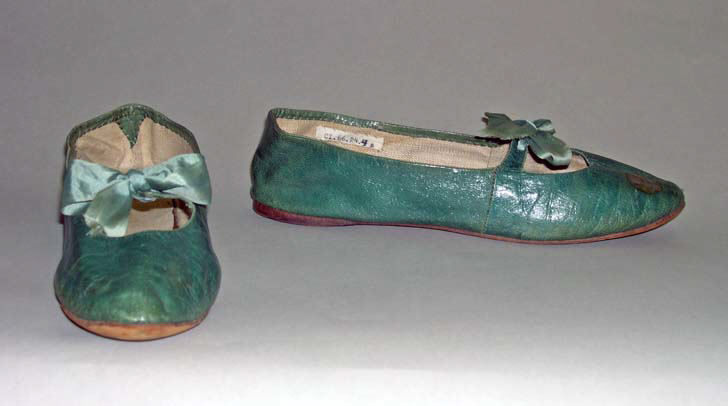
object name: slipper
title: Slippers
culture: american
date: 1810-1819